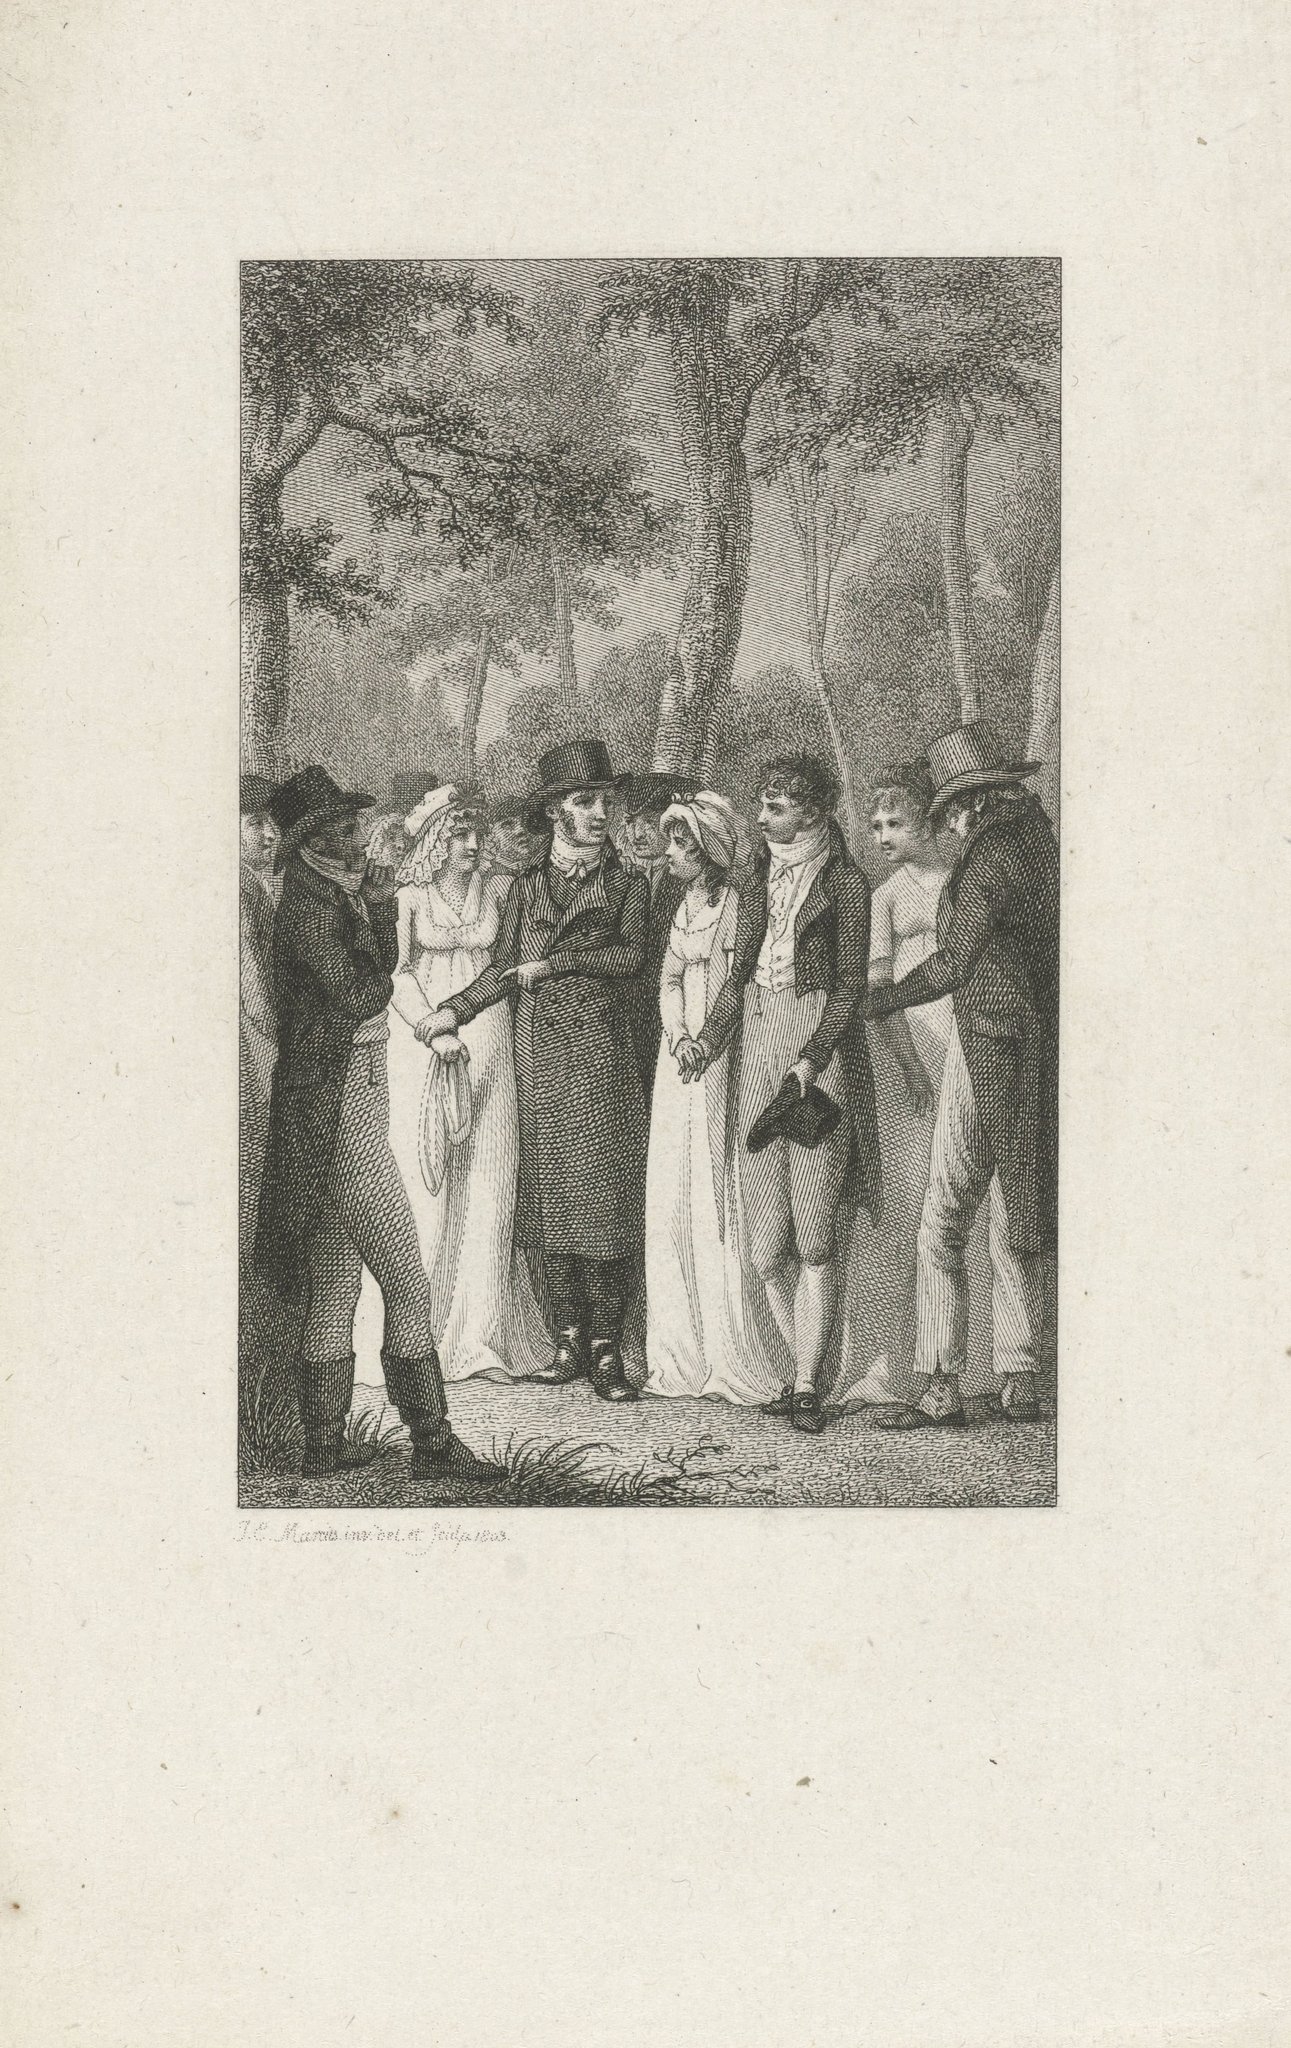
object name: print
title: Gezelschap in een bos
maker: jacob ernst marcus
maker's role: draughtsman, print maker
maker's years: 1774-1826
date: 1803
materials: paper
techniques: etching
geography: amsterdam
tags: conversation, dialogue; conversation piece, forest, wood (+ landscape with figures, staffage)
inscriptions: collector's mark: Lugt 2228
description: Verschillende paren van heren en dames, elkaars hand vasthoudend, in een landschap met bomen. Links een man met een hand aan zijn kin.